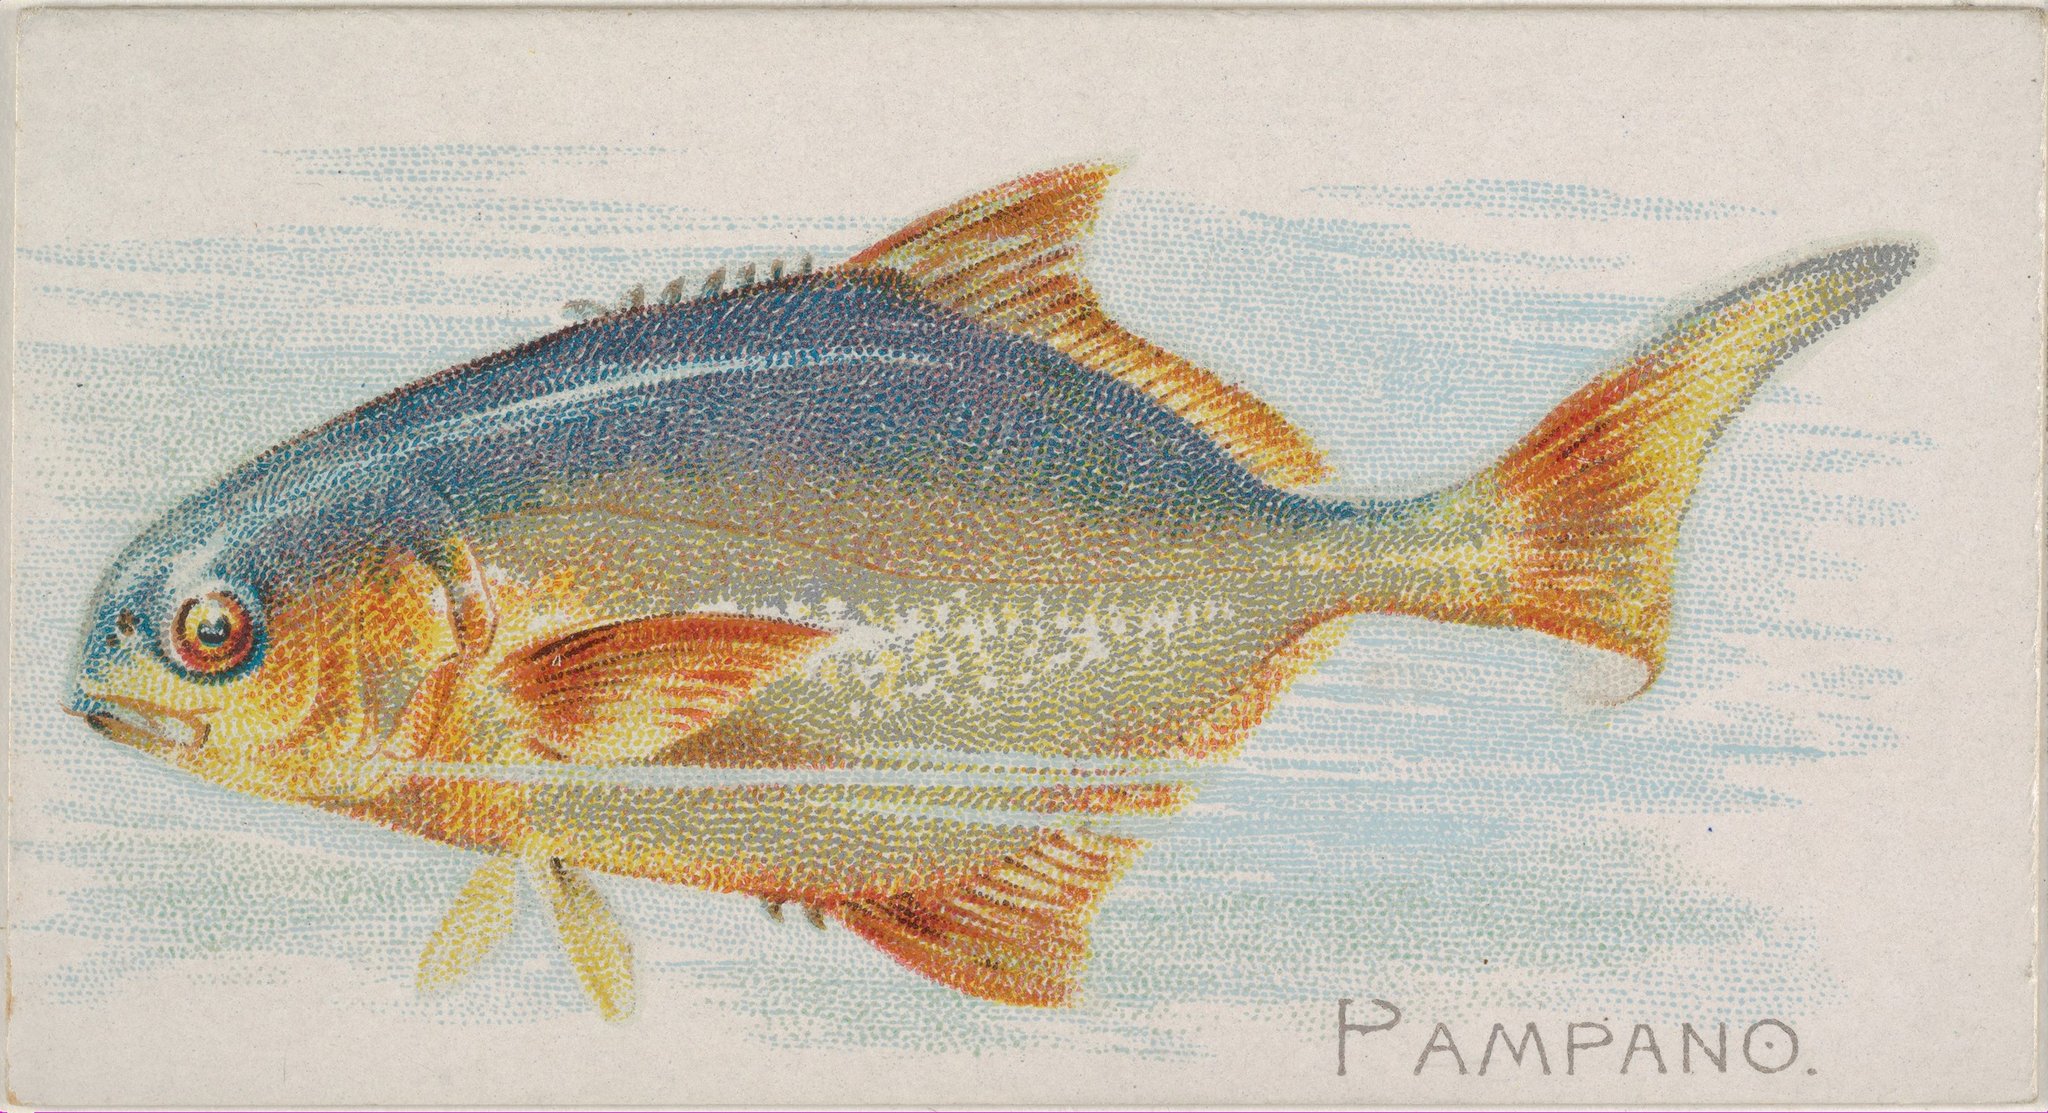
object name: print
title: Pampano, from the Fish from American Waters series (N8) for Allen & Ginter Cigarettes Brands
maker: allen & ginter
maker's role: publisher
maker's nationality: american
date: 1889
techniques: color lithograph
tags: fish